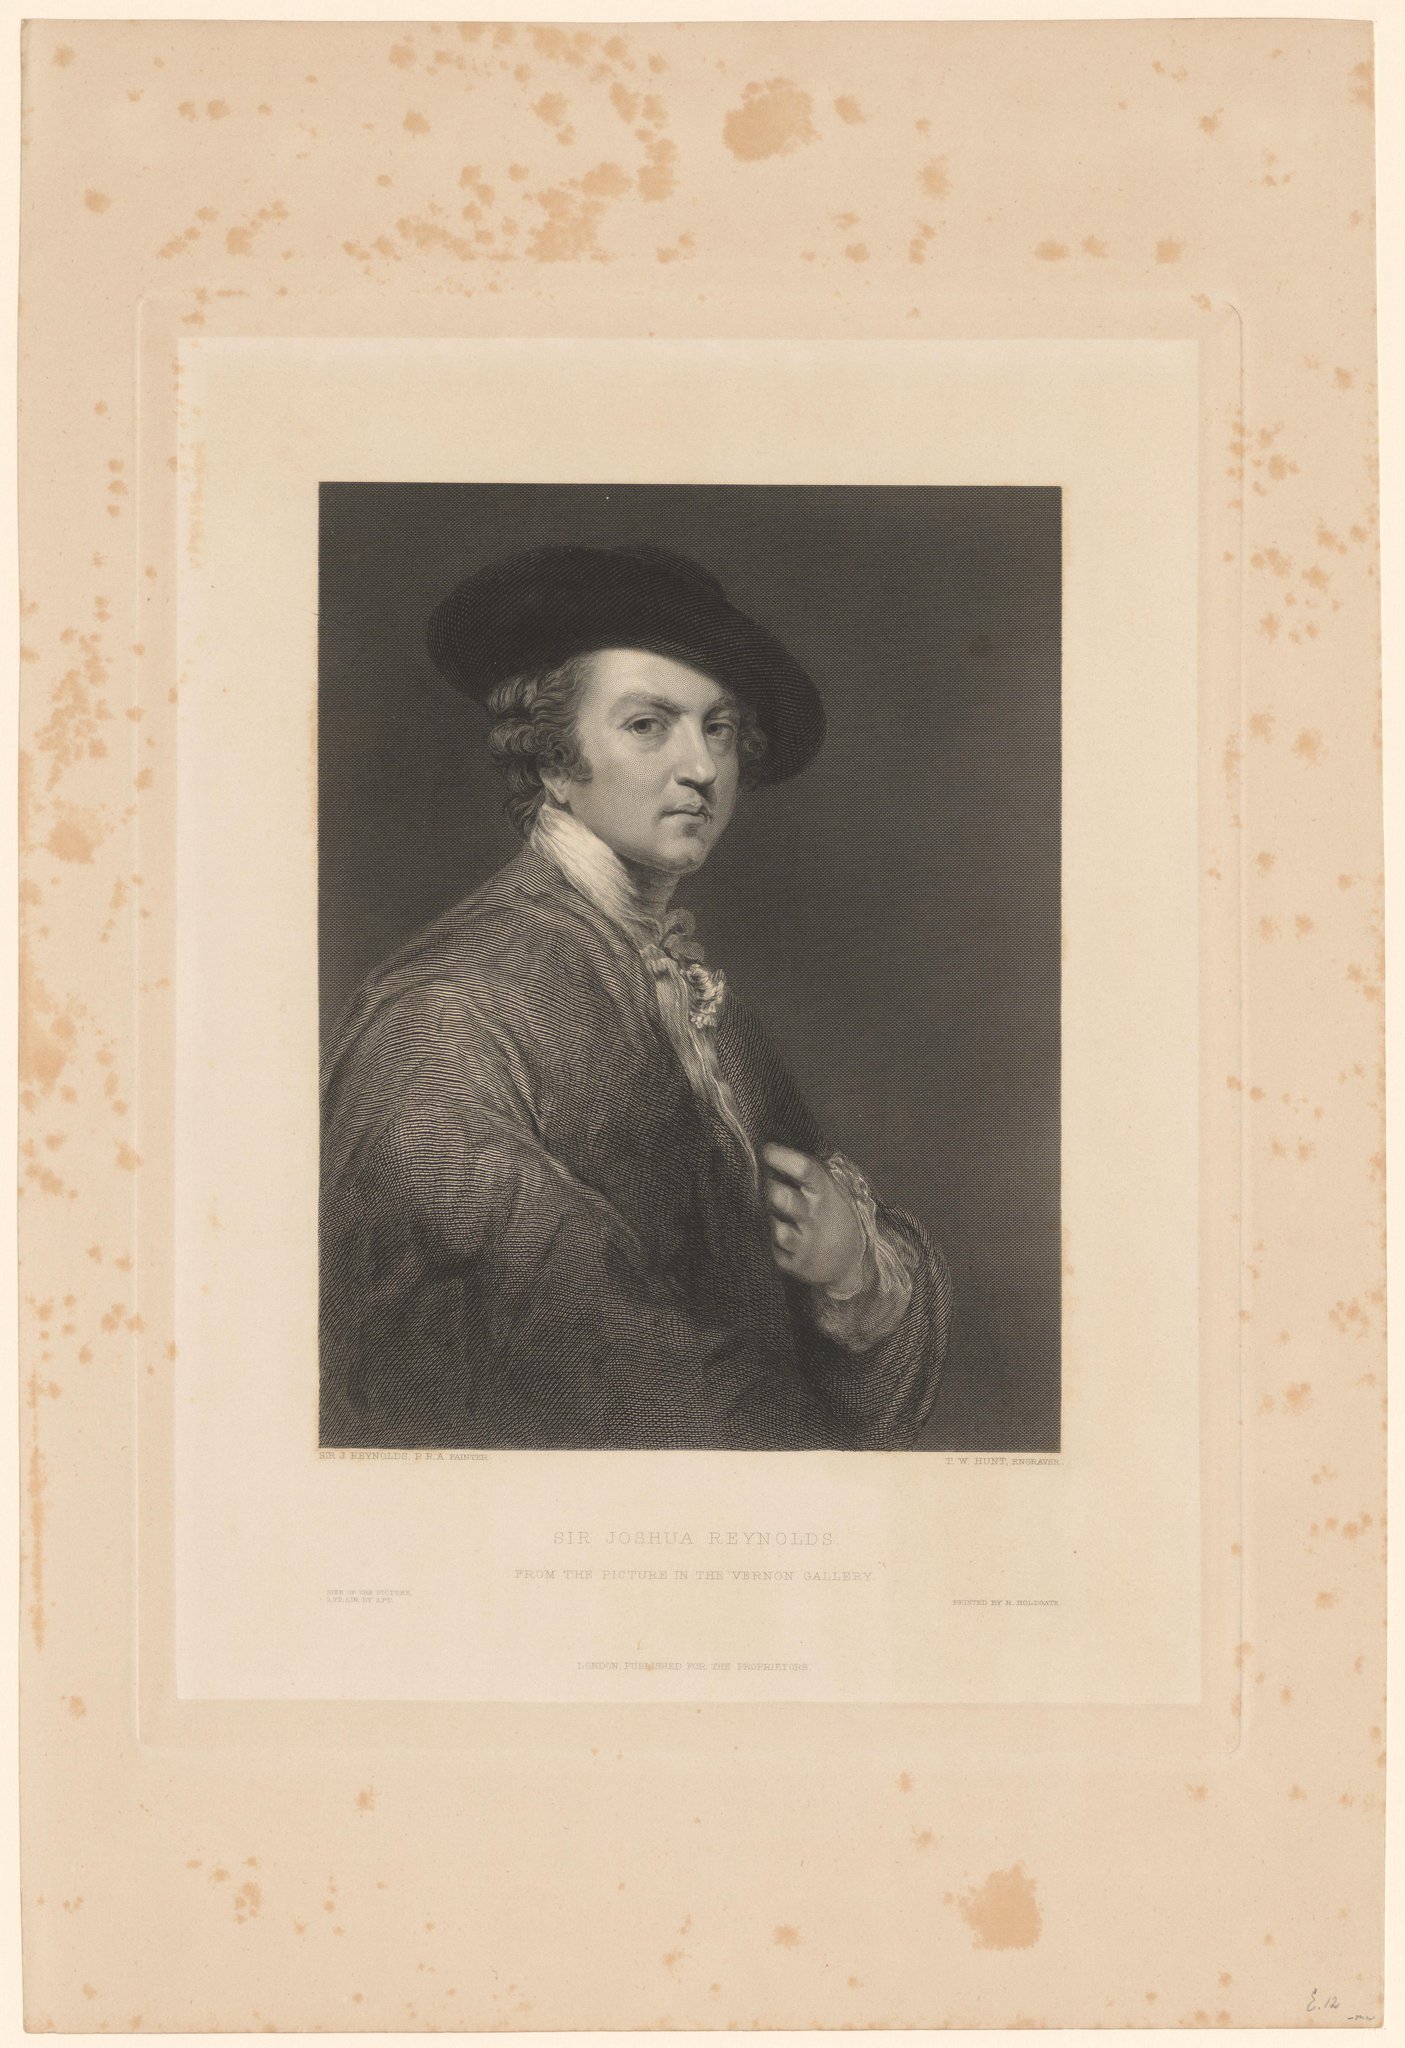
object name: print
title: Portret van Joshua Reynolds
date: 1860-1868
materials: paper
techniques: engraving, etching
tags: painter, joshua reynolds, historical persons, portrait, self-portrait of painter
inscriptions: collector's mark: Lugt 2228